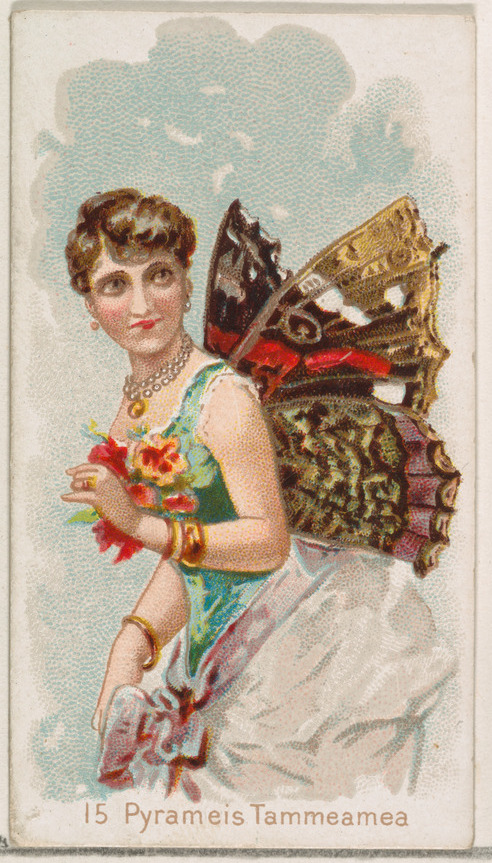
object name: print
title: Card 15, Pyrameis Tammeamea, from the Butterflies series (N183) issued by Wm. S. Kimball & Co.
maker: william s. kimball & company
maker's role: publisher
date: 1888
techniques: color lithograph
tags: women